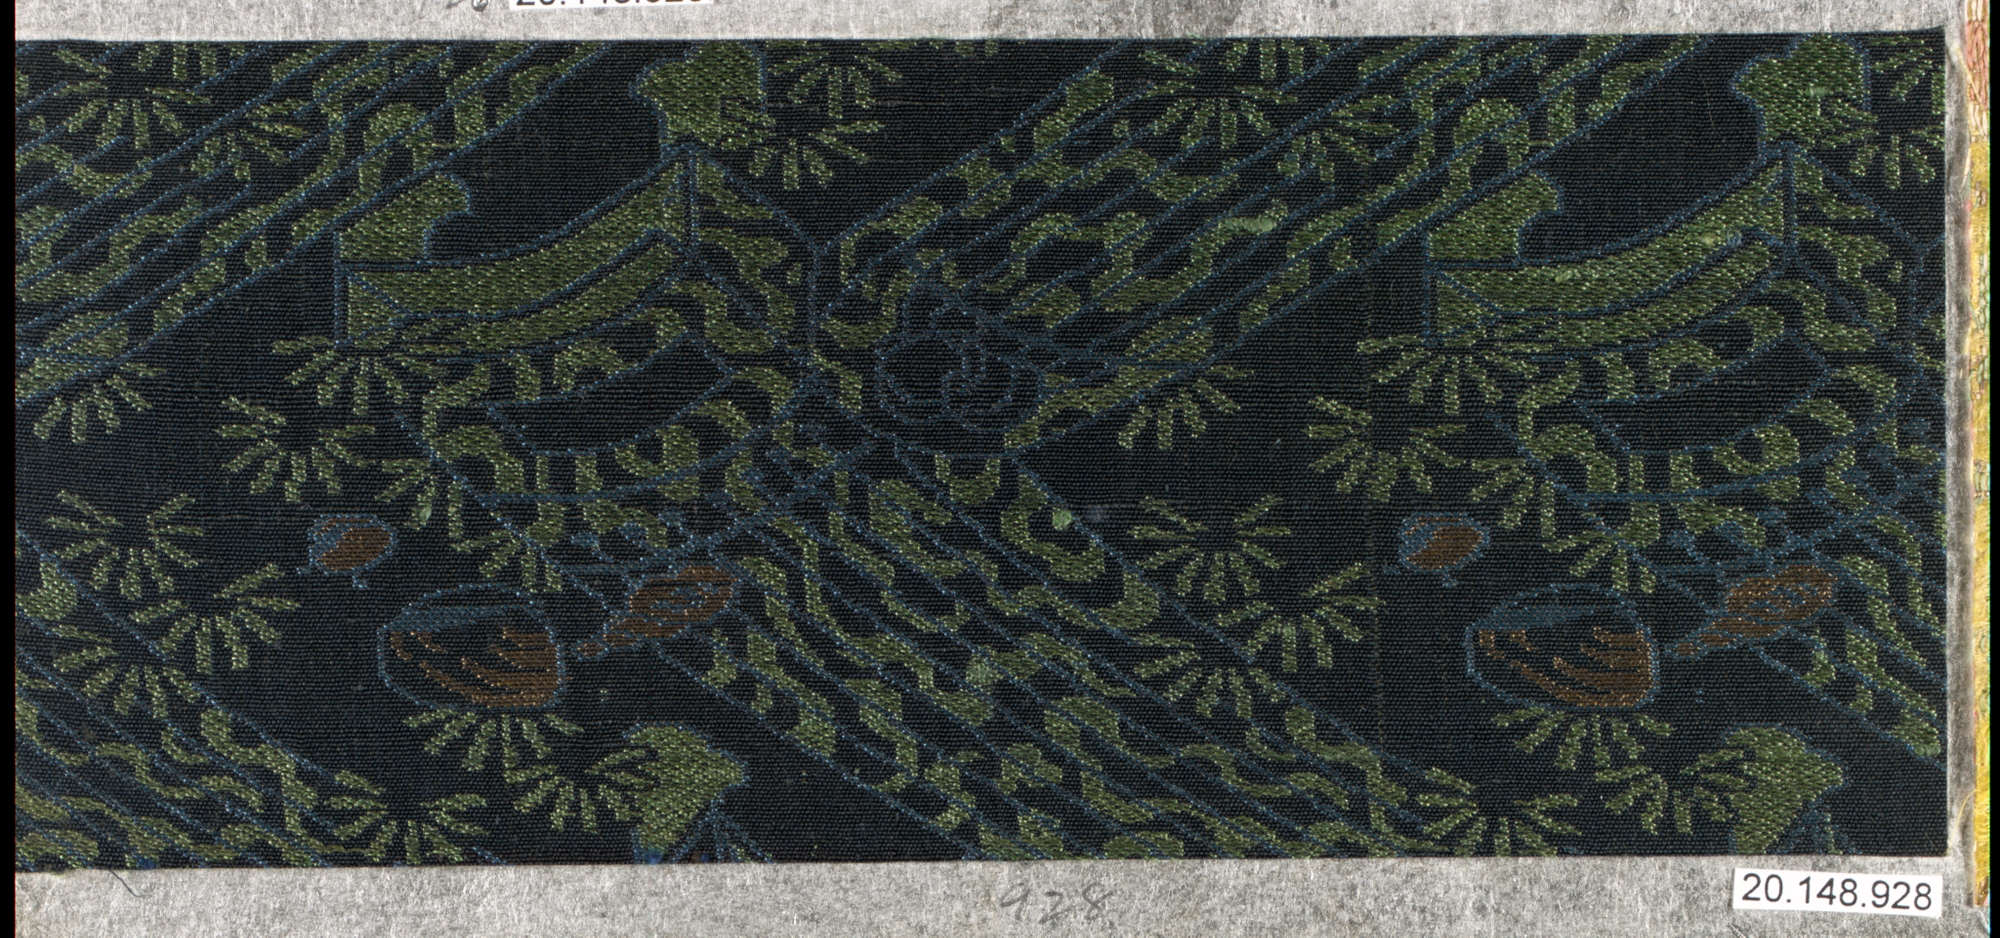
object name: piece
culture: japanese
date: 1701-1800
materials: silk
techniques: compound weave